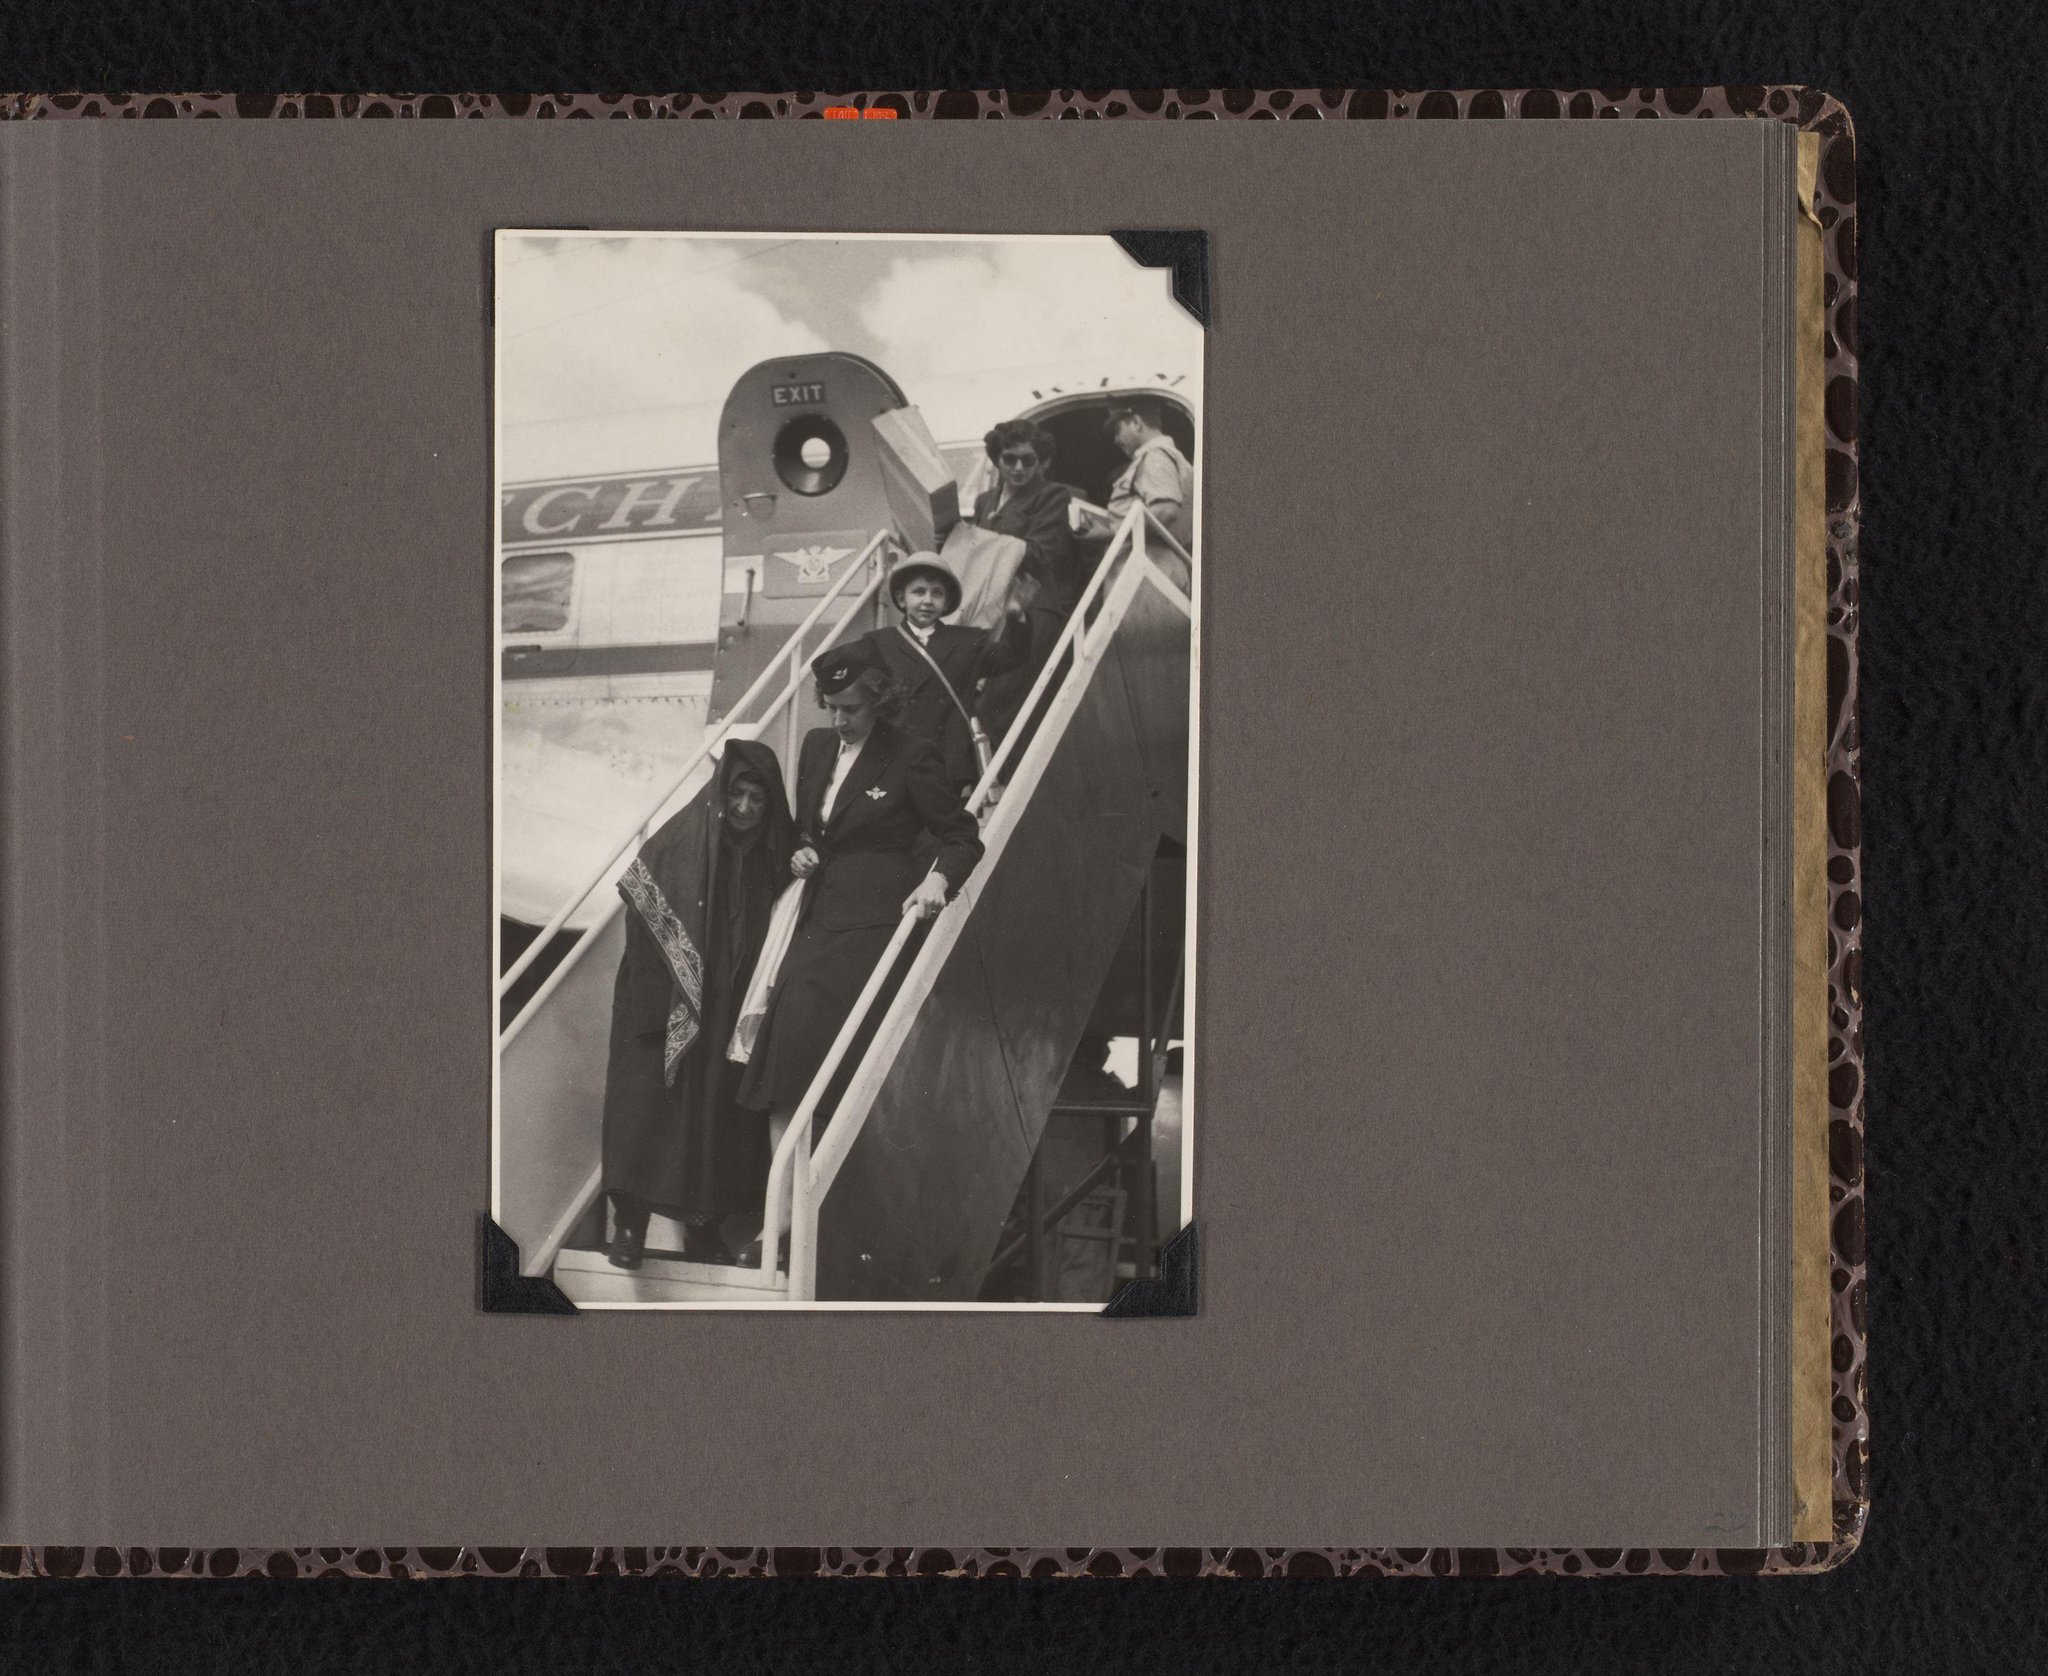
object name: photograph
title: Isabel Wachenheimer als stewardess op een uitgangstrap van een vliegtuig tijdens haar periode bij KLM, 1947-1955, Israël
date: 1947-1955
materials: cardboard, photographic support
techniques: gelatin silver print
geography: tel aviv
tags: leiden, isabel wachenheimer-elon, aircraft, aeroplane, air hostess, stewardess, steward, purser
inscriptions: name: ‘Lydda Airport Photographer, Israel’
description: Blad bevat één foto van Isabel Wachenheimer die een oude vrouw de trap afhelpt, en andere onbekende passagiers. Uit album half formaat, kunstlederen omslag met koordbinding.